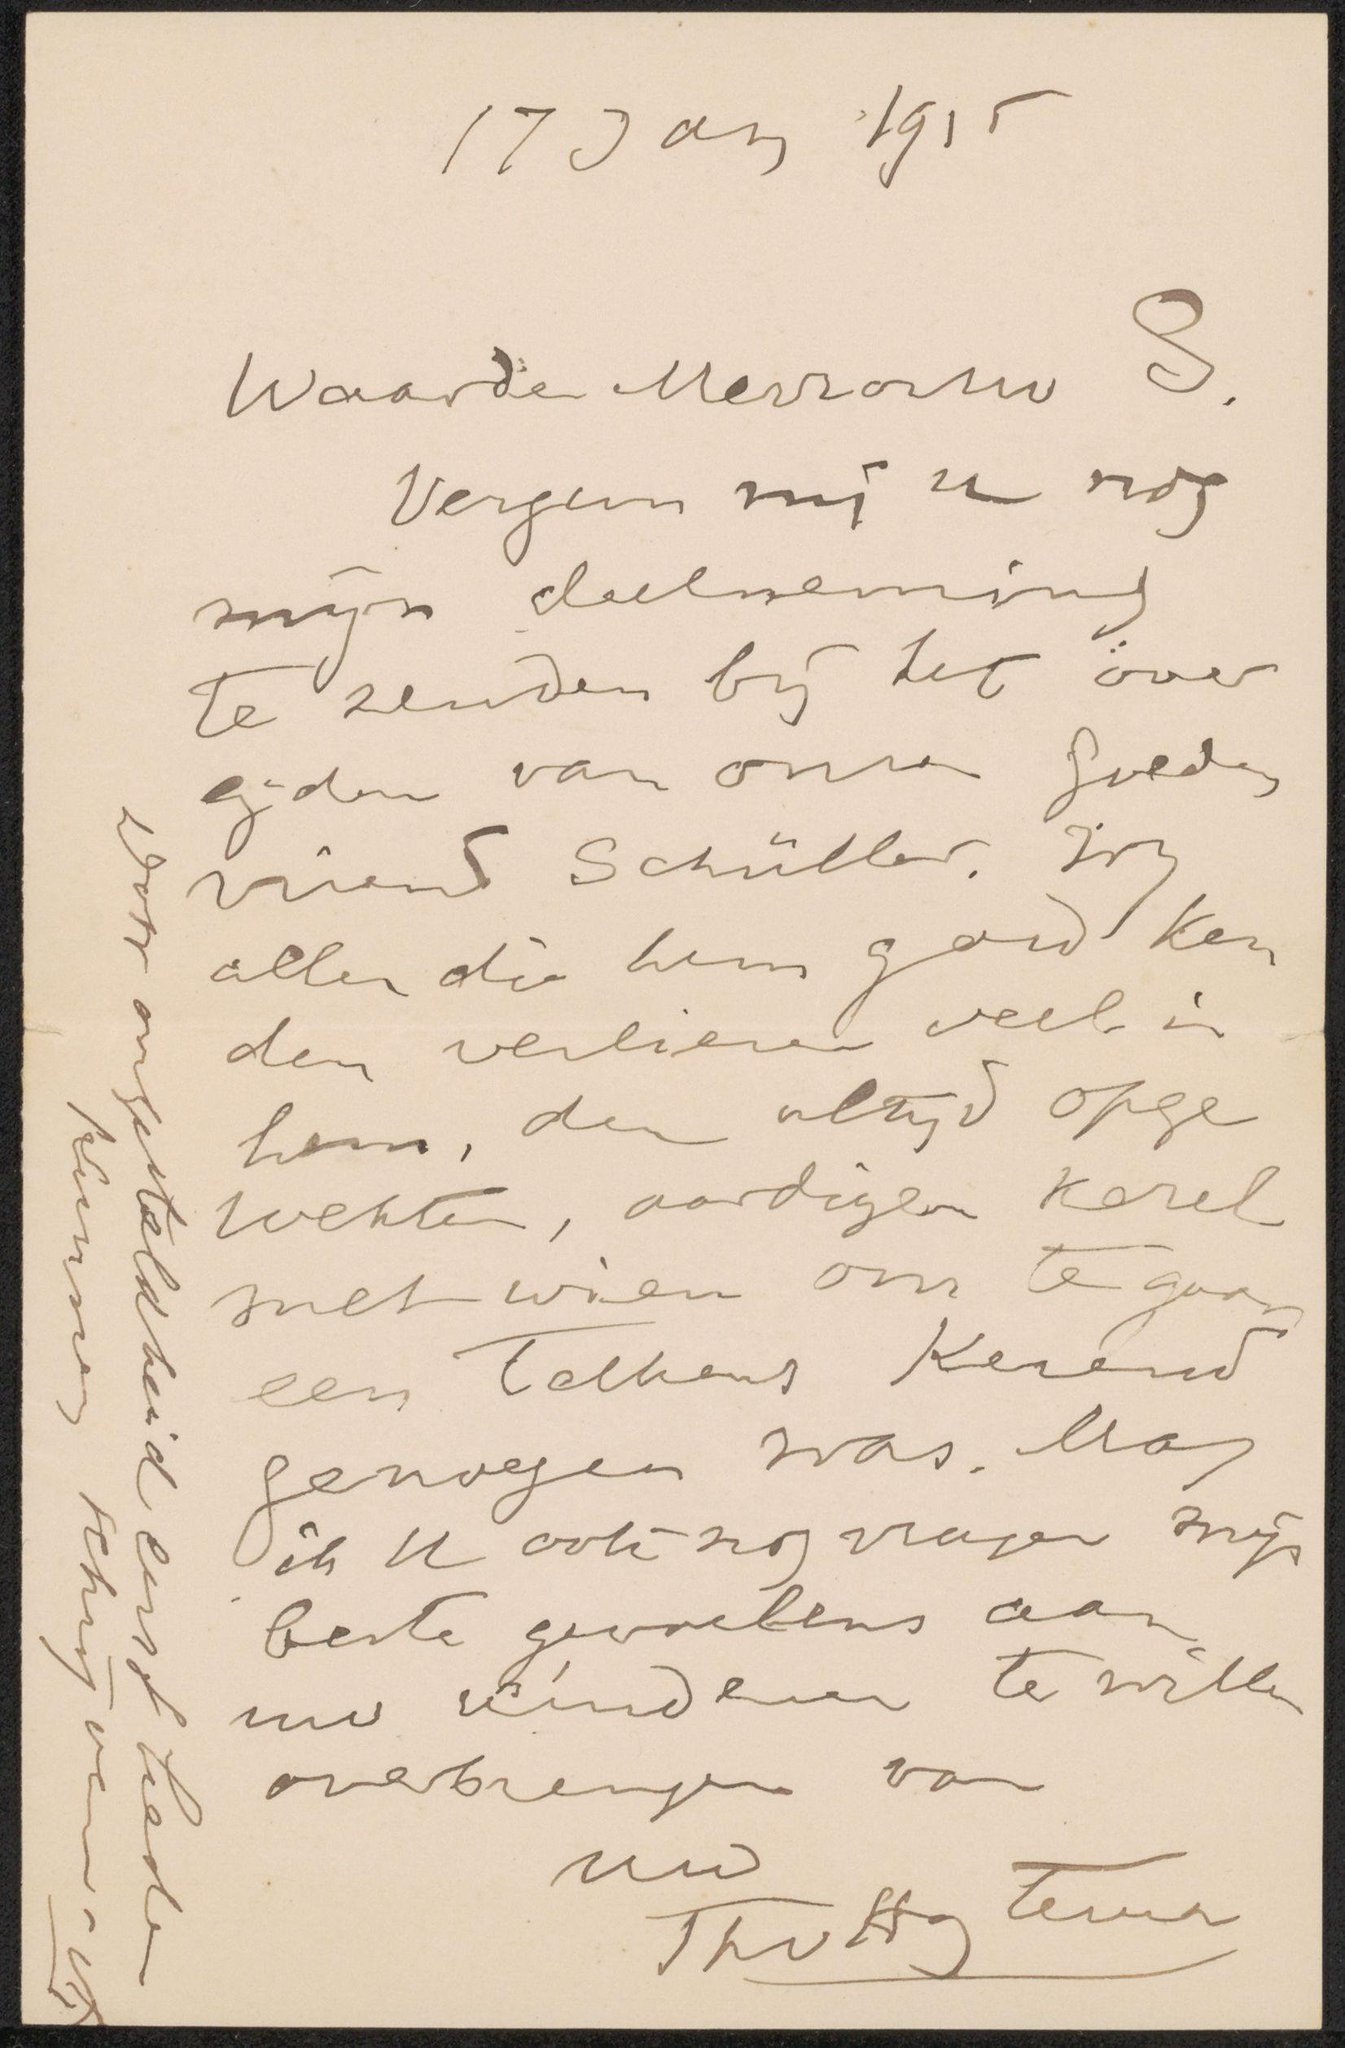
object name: letter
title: Brief aan E.H. Schüller-Audretsch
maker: Anonymous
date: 1915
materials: ink, paper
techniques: pen, writing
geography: rotterdam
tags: painter, print maker, draughtsman, jan schüller, family life, diseases